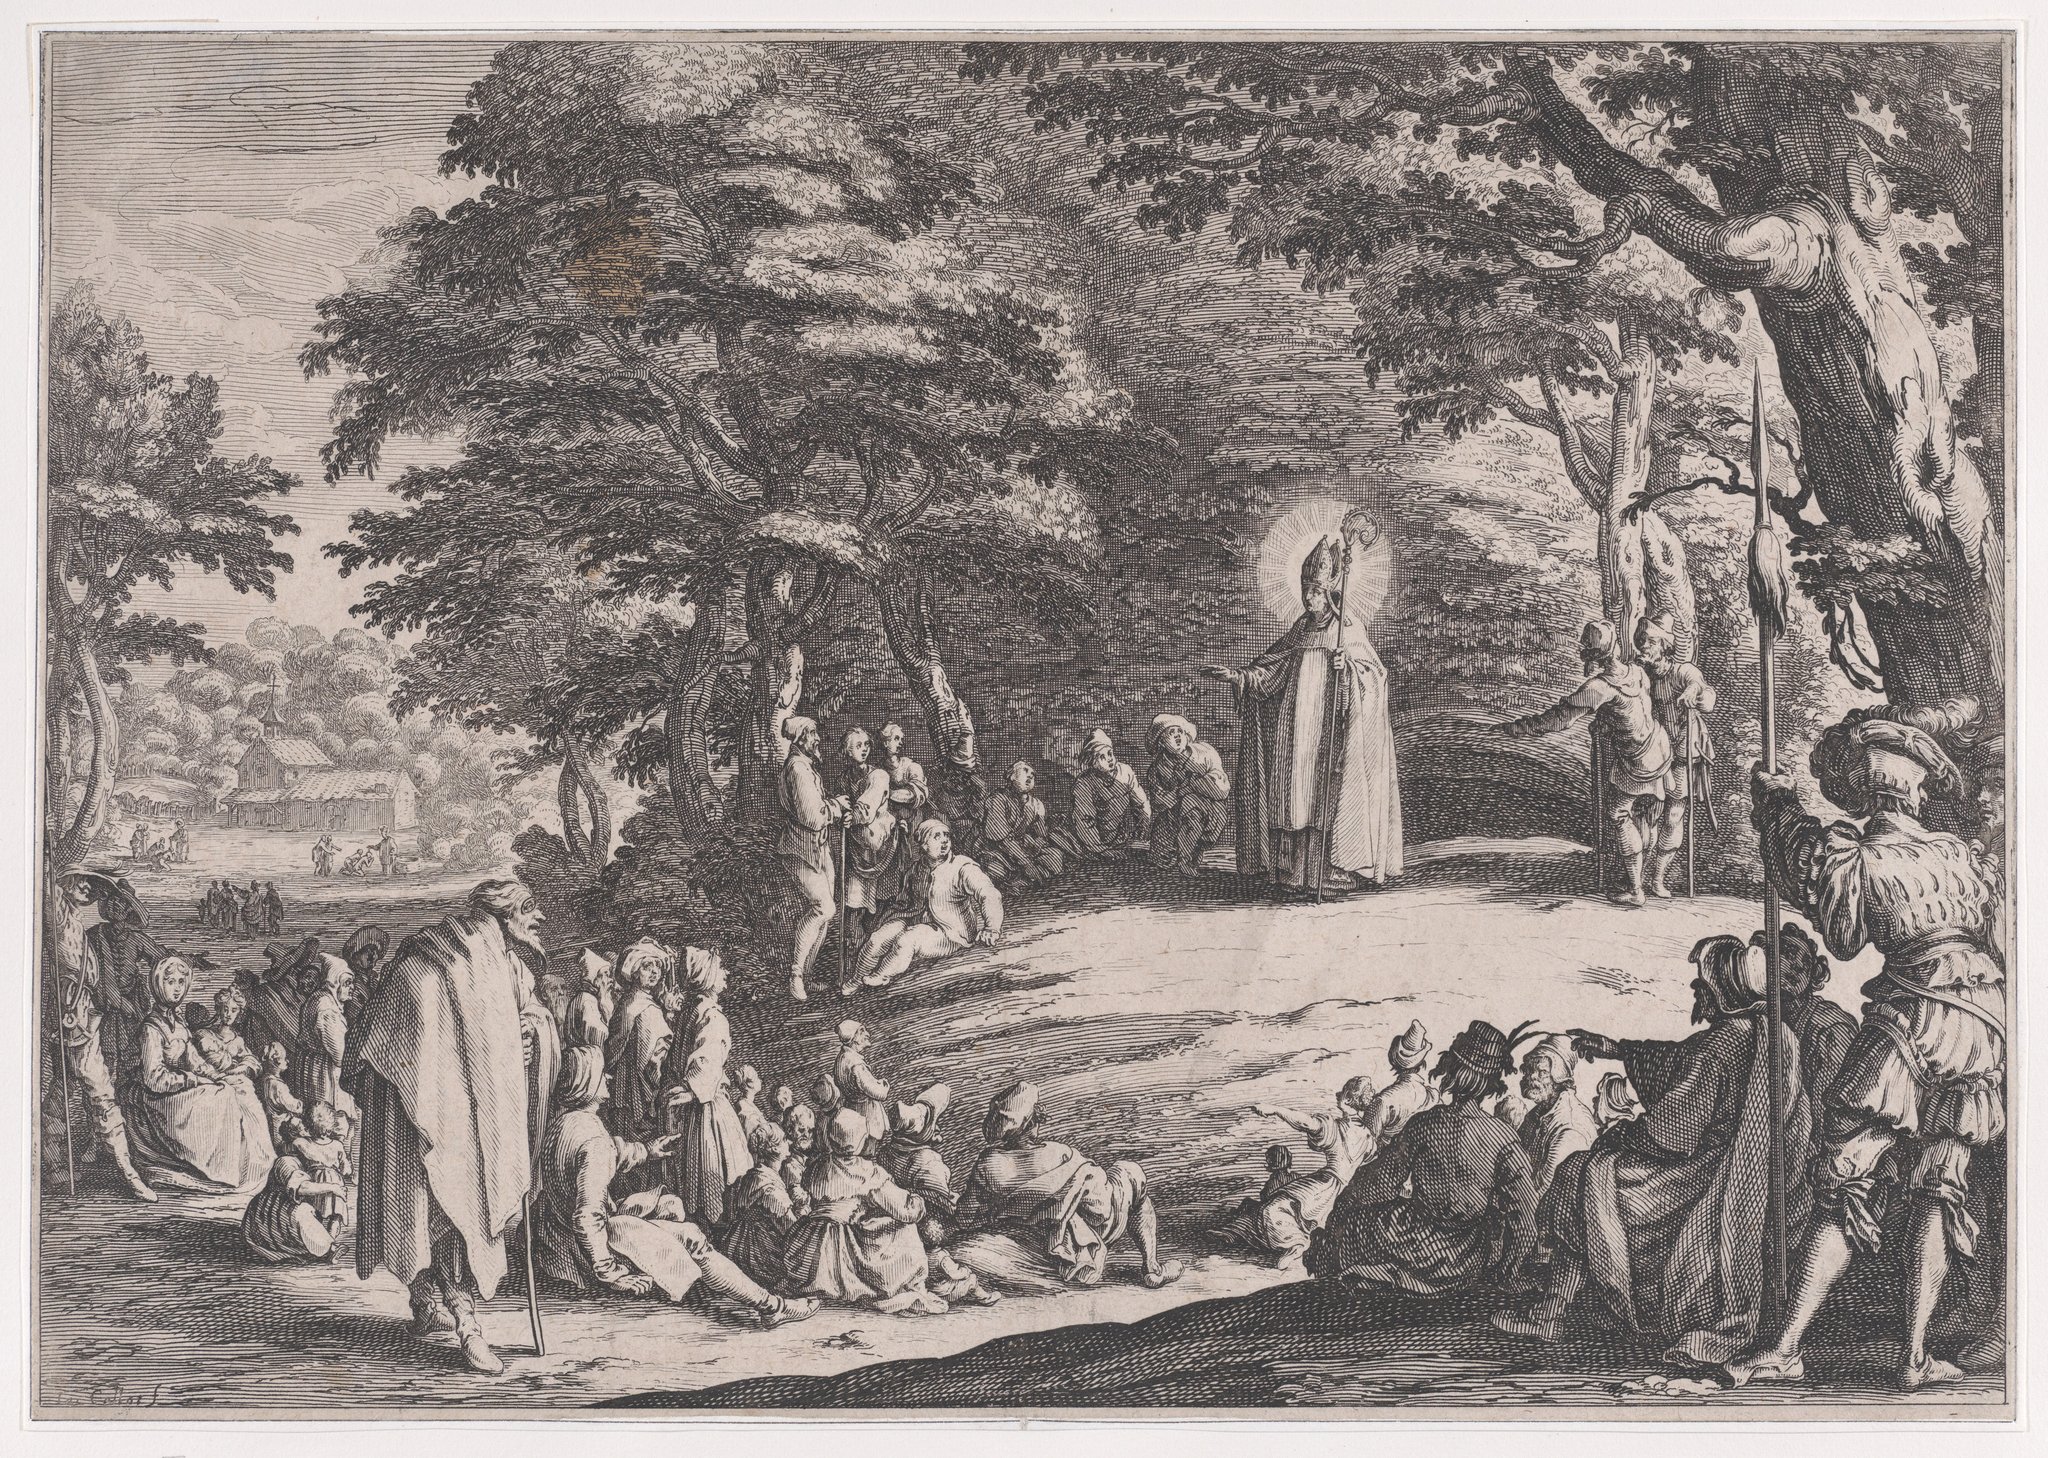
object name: print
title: Saint Amond, St. Nicholas, or St. Séverin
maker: jacques callot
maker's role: artist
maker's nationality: french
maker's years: 1592-1635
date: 1625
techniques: engraving, etching